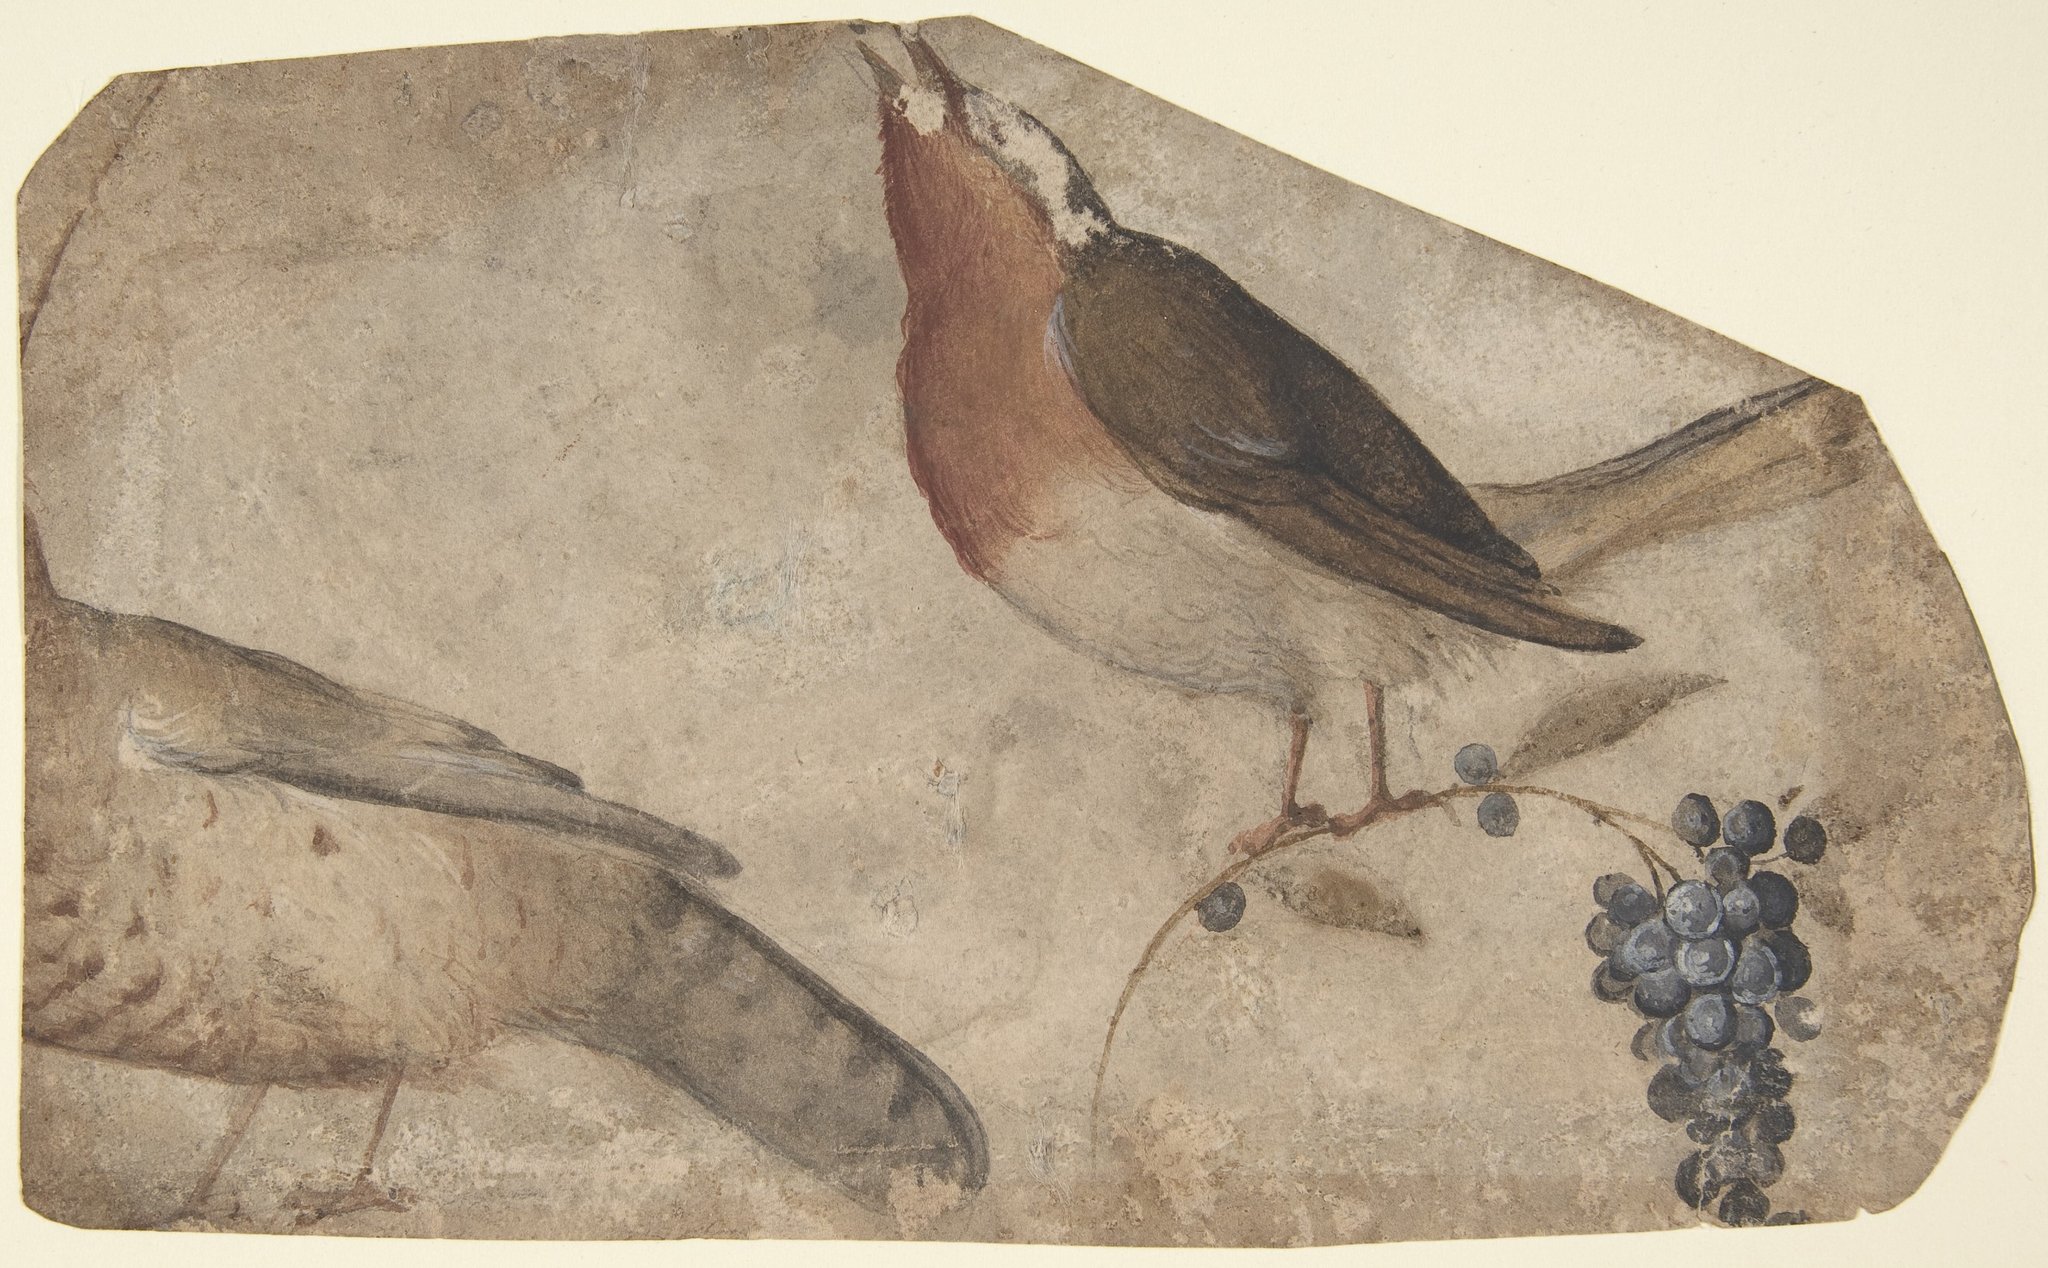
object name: drawing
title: Bird Eating Grapes (recto); Tigress (verso)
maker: giovanni da udine (giovanni dei ricamatori)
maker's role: artist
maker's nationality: italian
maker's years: 1487-1564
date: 1487-1564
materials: gouache, watercolor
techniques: brush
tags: birds,tigers